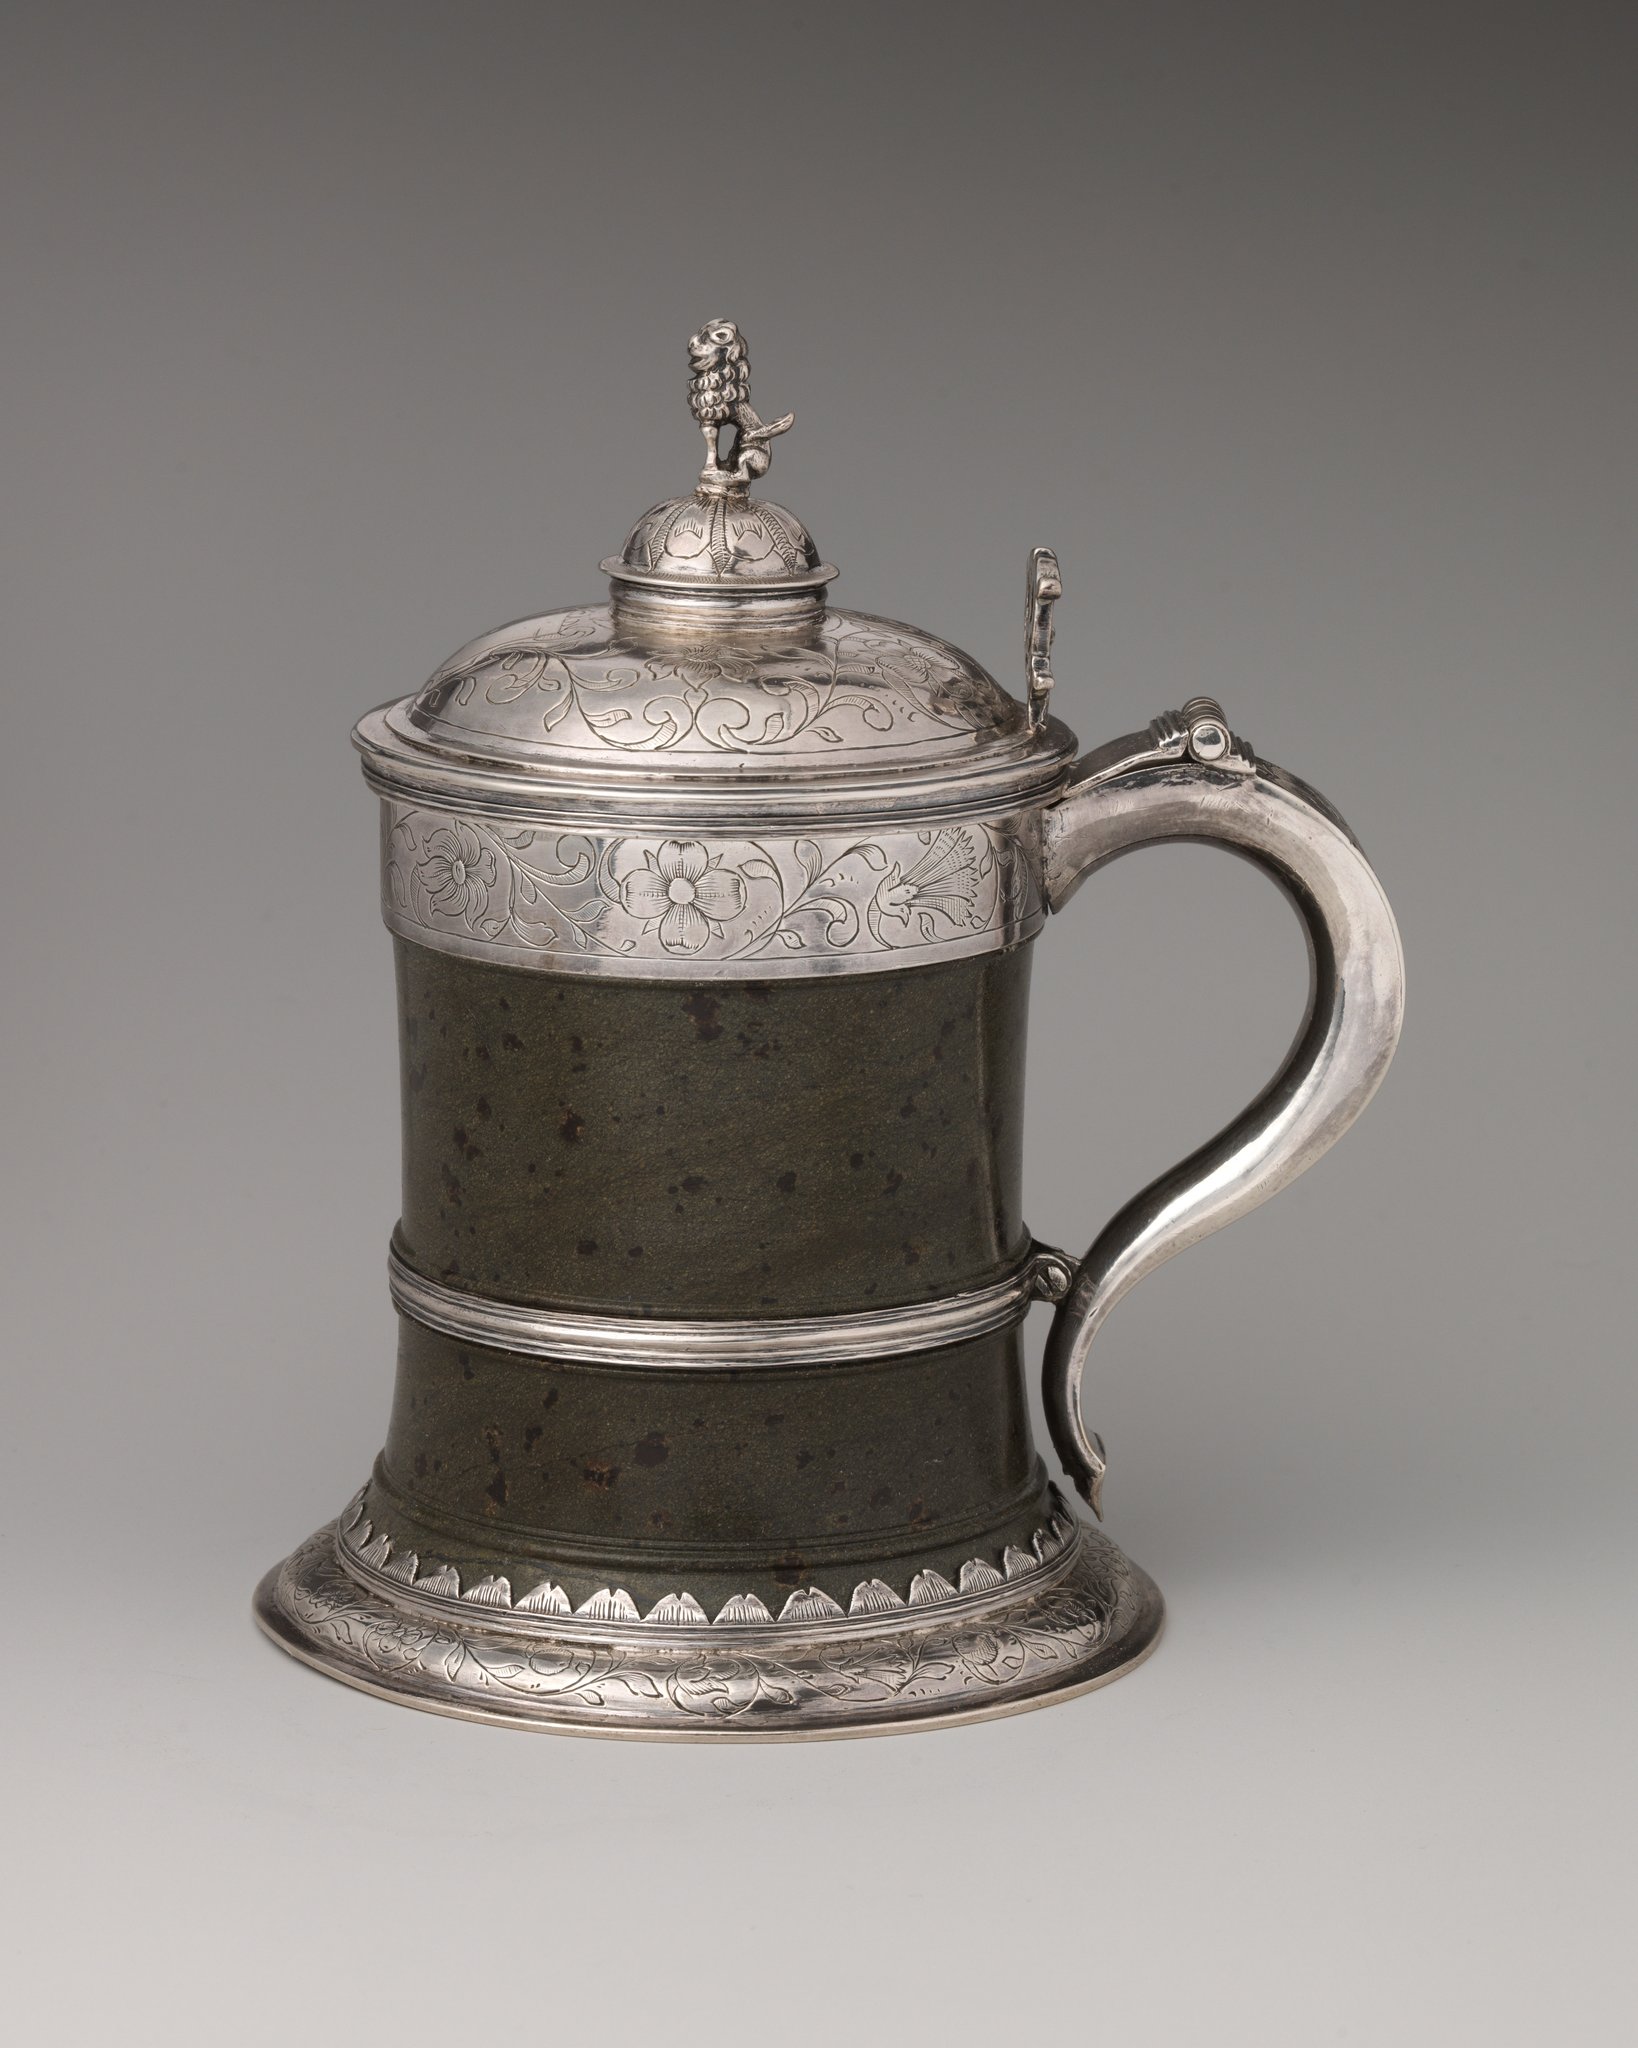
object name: tankard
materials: stone, silver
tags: lions,flowers